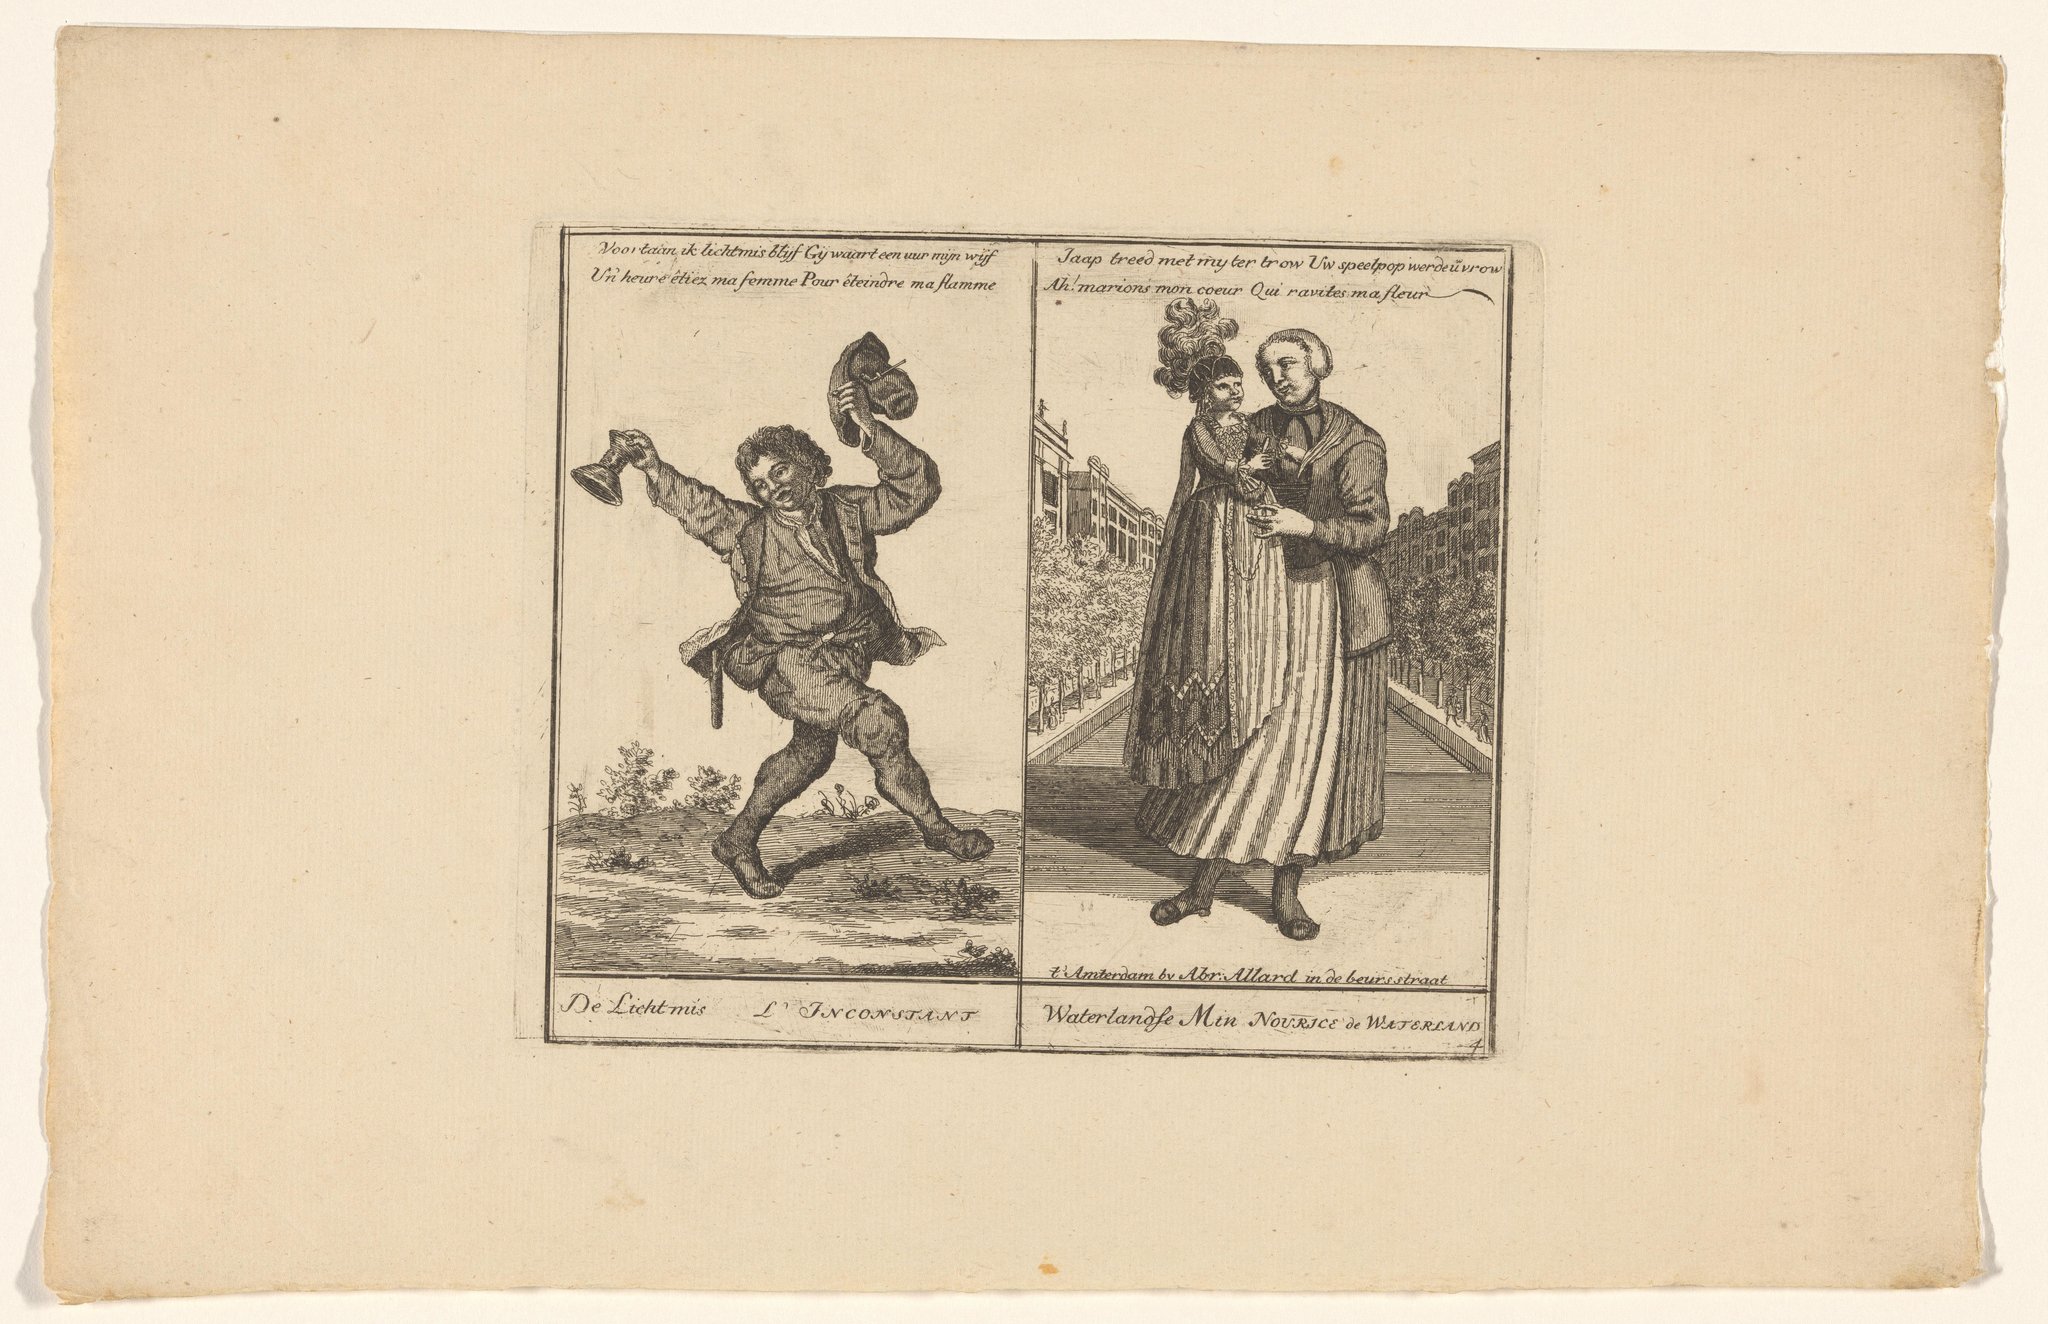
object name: print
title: Hollandse Dorpelingen enz. Tweede Deel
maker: abraham allard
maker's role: print maker, publisher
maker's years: 1676-1725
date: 1676-1725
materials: paper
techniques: etching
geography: amsterdam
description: Links een huppelende knaap met llege drinkbeker. Rechts een min met klein kind op de arm.